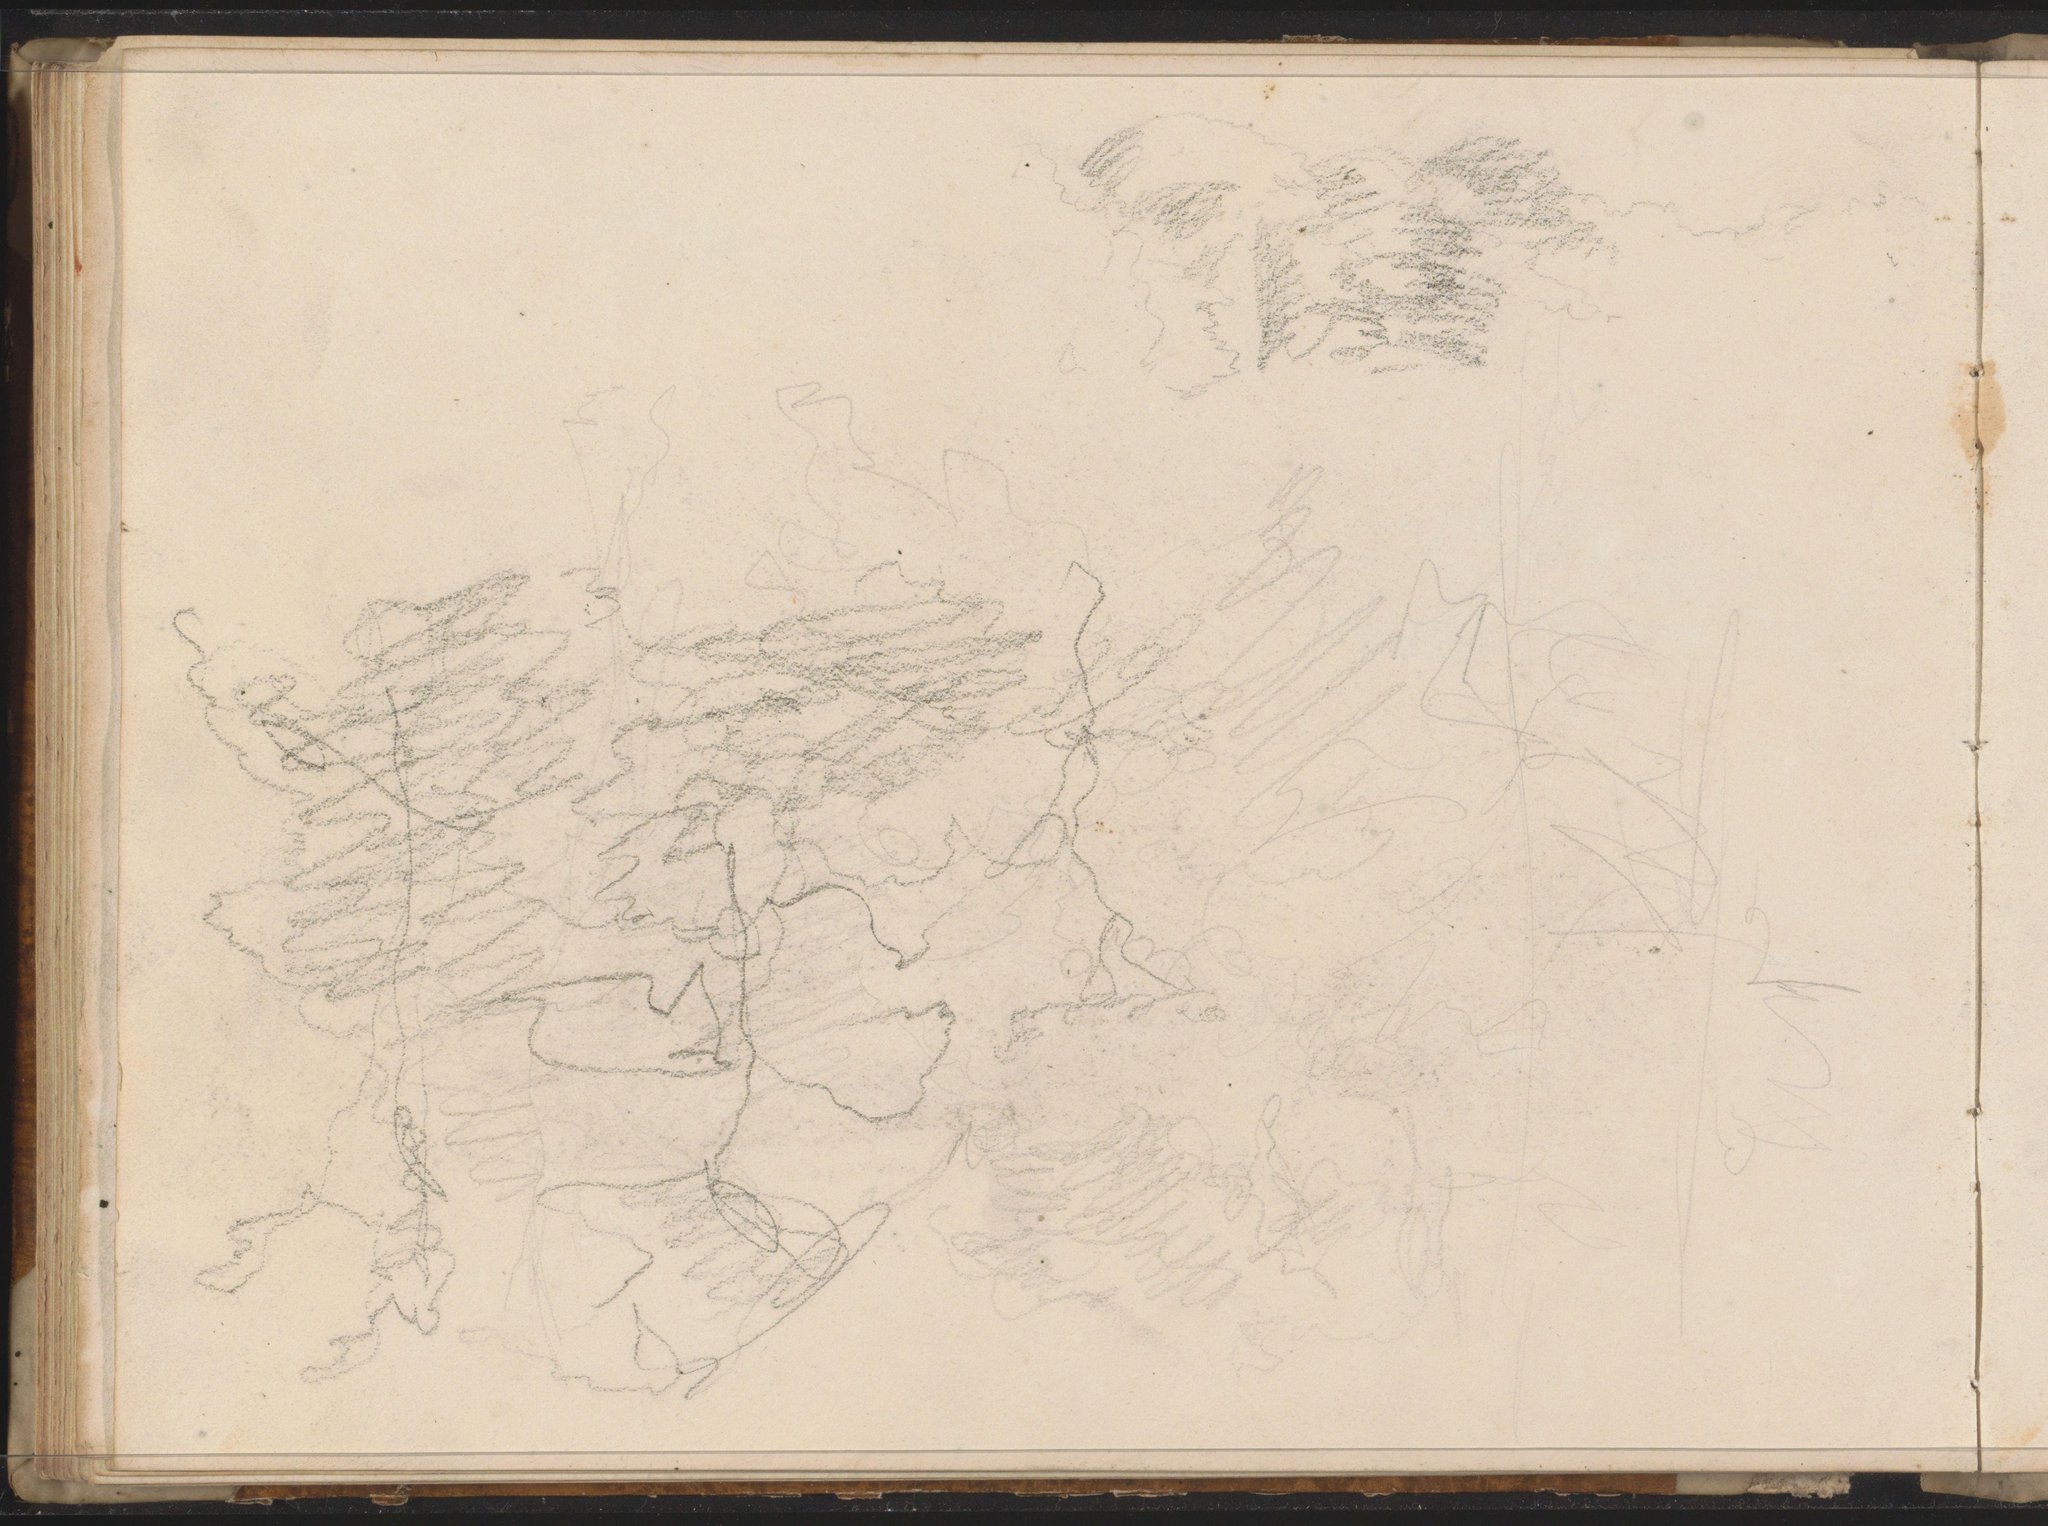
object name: sketchbook leaf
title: Studies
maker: maria vos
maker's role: draughtsman, painter, print maker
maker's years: 1824-1906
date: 1834-1906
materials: paper, pencil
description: Blad 37 verso uit een schetsboek met 39 bladen.